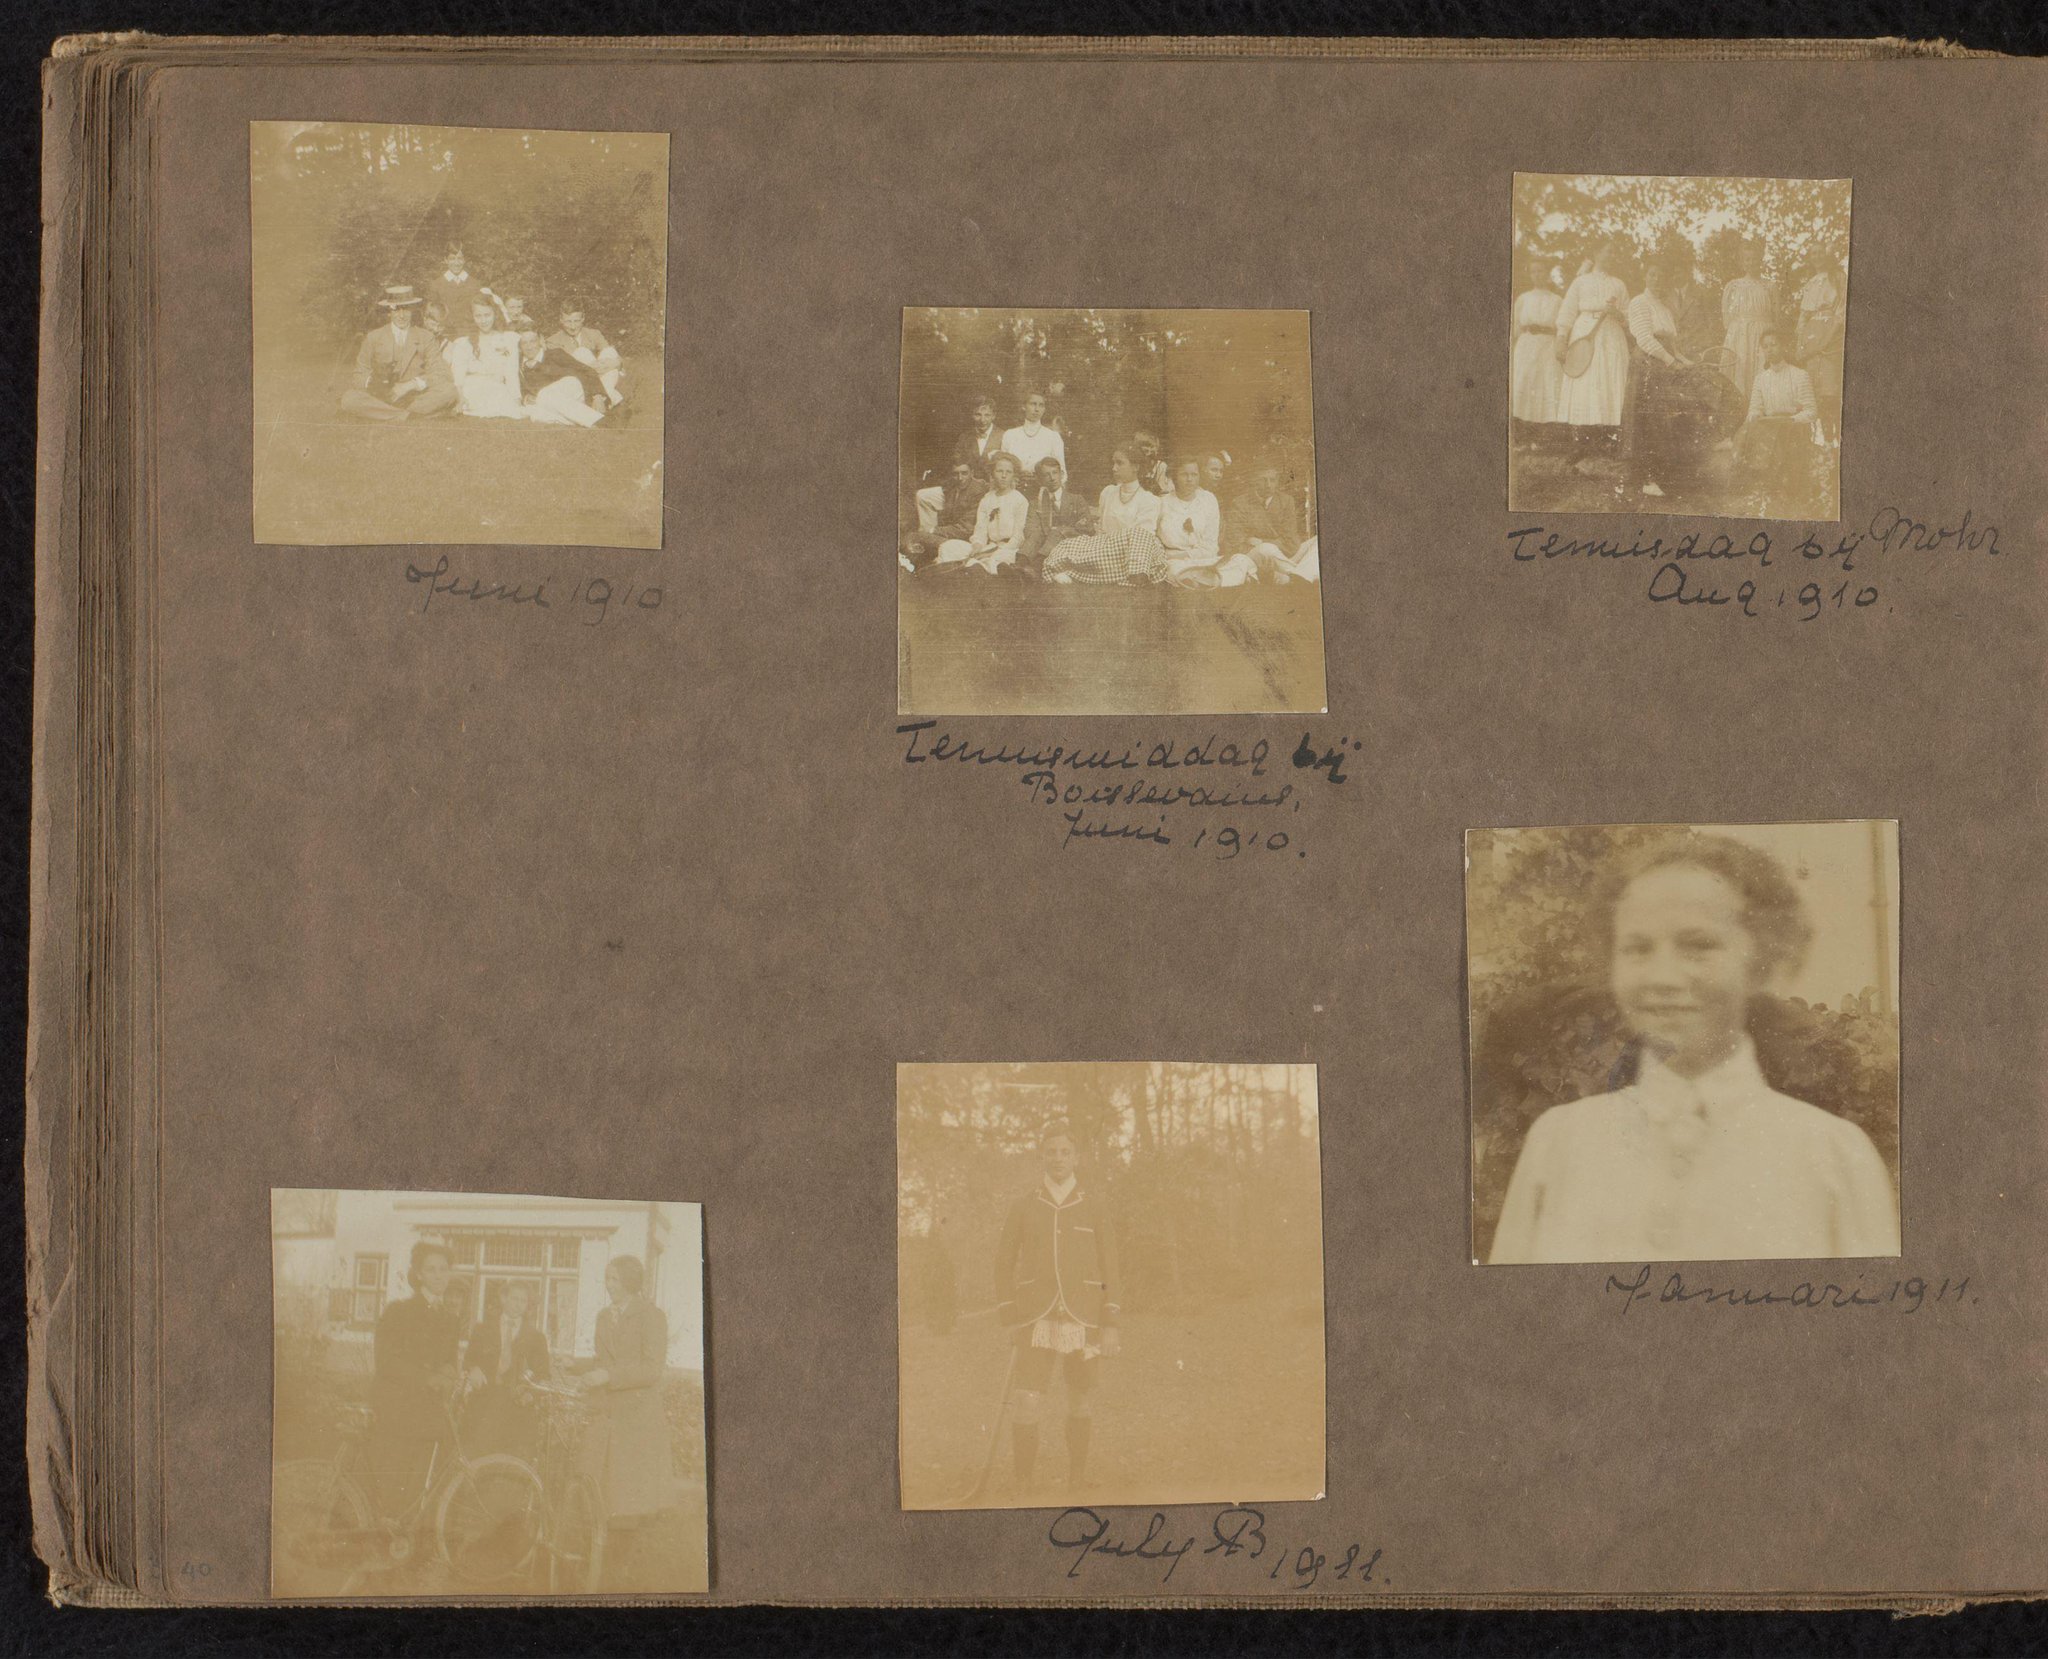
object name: album leaf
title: Zes foto's van vrienden van Loentje Onnen bij tenniswedstrijden en met fietsen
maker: carolina frederika onnen (lien/loen)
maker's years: 1896-1983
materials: paper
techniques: gelatin silver print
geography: hilversum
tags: batavia, amsterdam, carolina frederika onnen (lien/loen), tennis, lawn-tennis, historical persons, bicycle, friends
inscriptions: inscription: ‘Januari 1911’, inscription: ‘Tennismiddag bij/ Boissevains./ Juni 1910.’, inscription: ‘Guly B/ 1911.’, inscription: ‘Juni 1910’, inscription: ‘Tennis-dag bij Mohr/ Aug. 1910’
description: Deze foto's maken deel uit van een album.